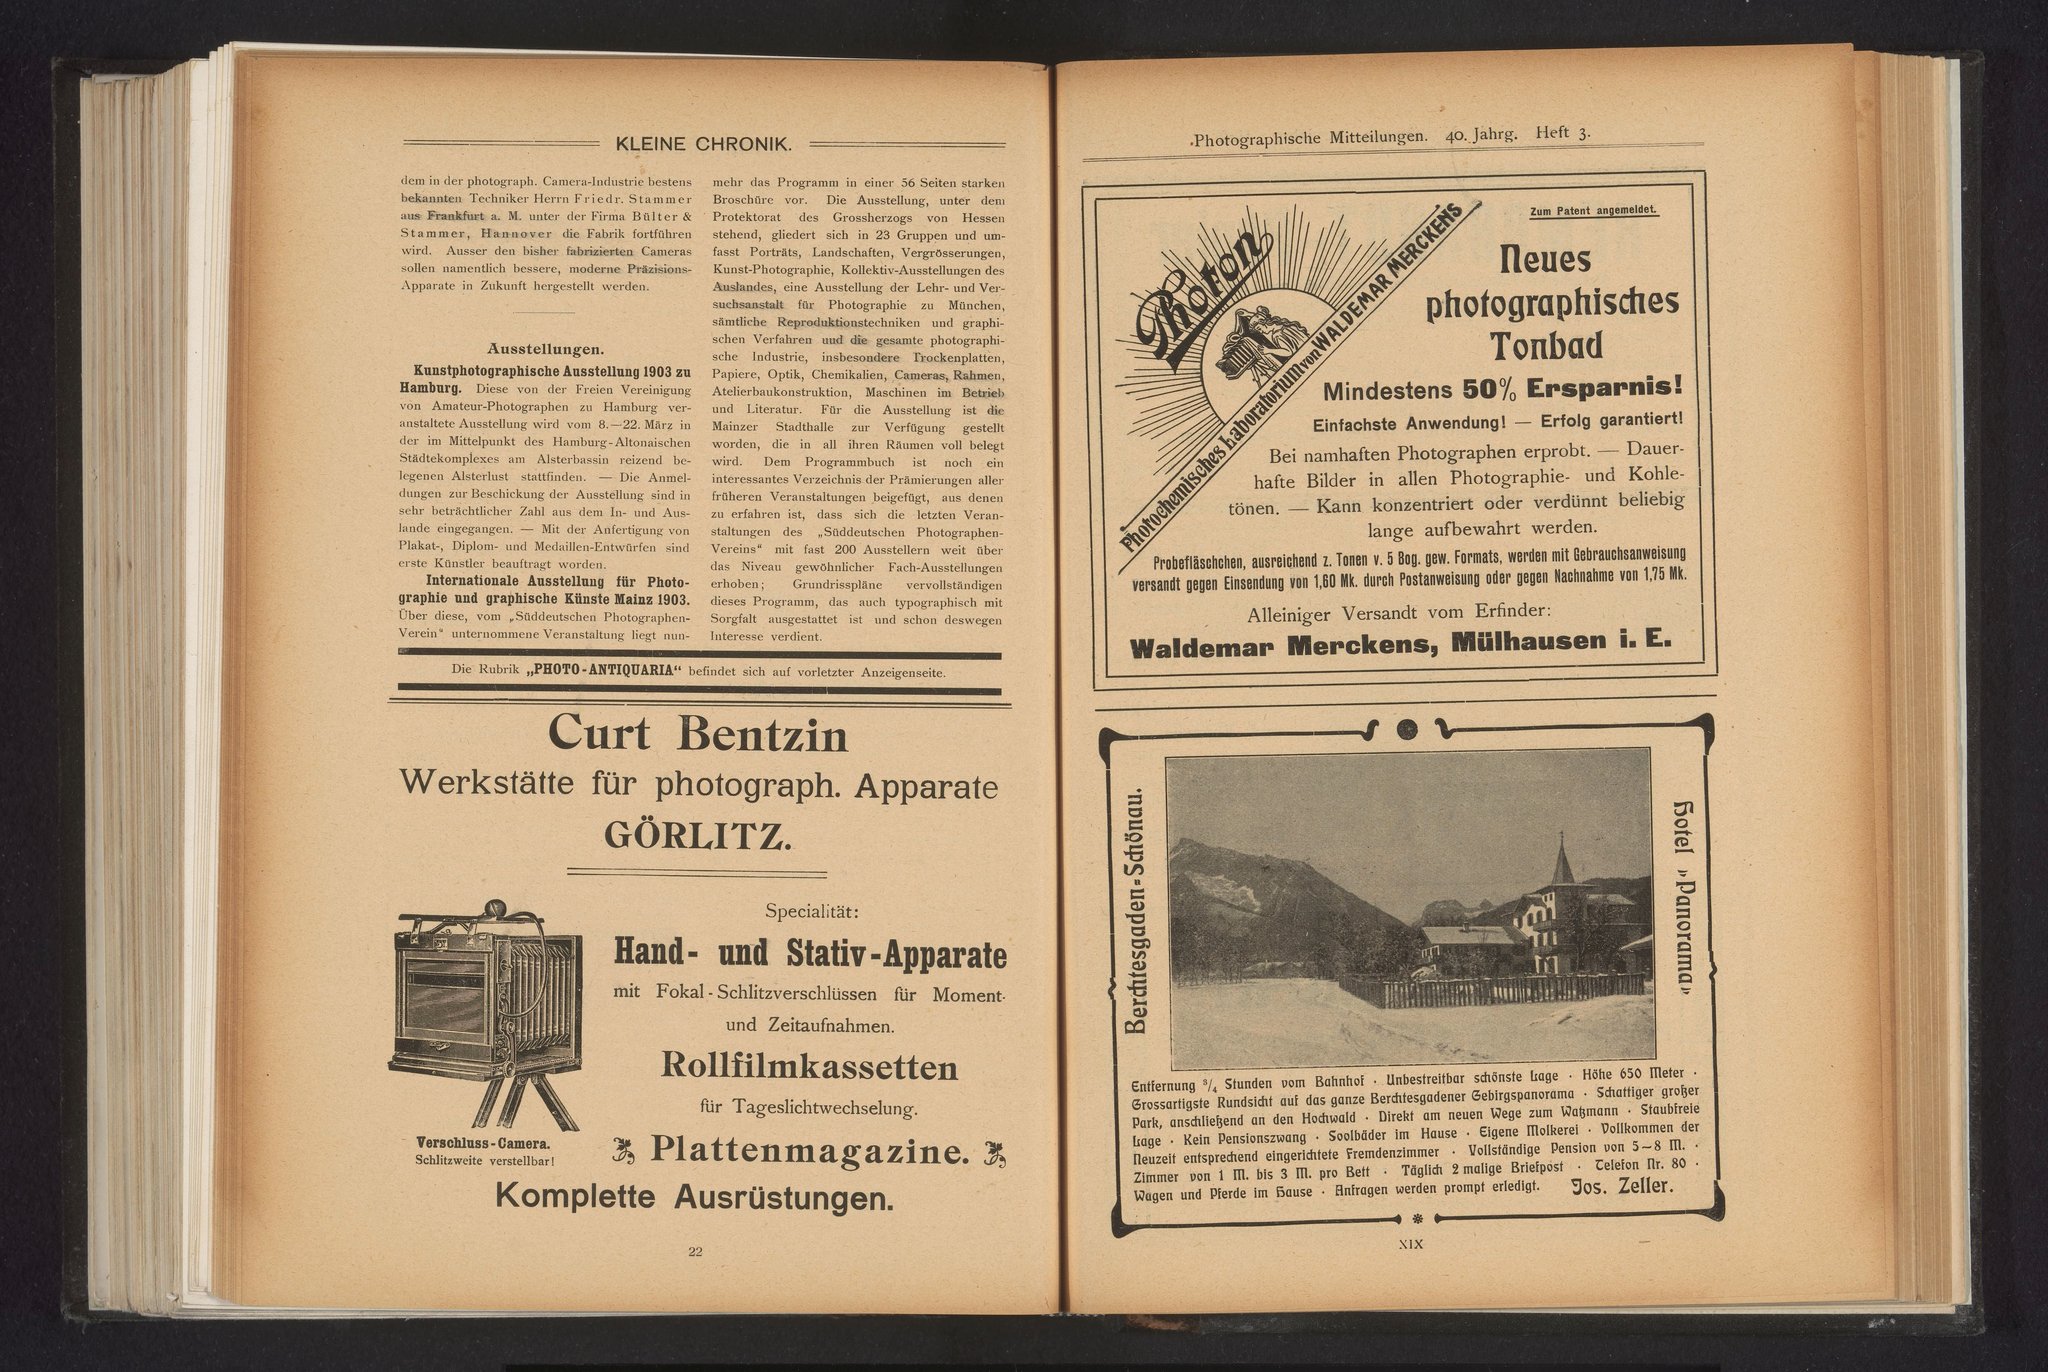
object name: photomechanical print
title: Berglandschap met hotel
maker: Anonymous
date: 1898-1903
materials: paper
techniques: autotype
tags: hotel, hostelry, inn, mountains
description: Prent tegenover pagina 22 van het reclameblok.